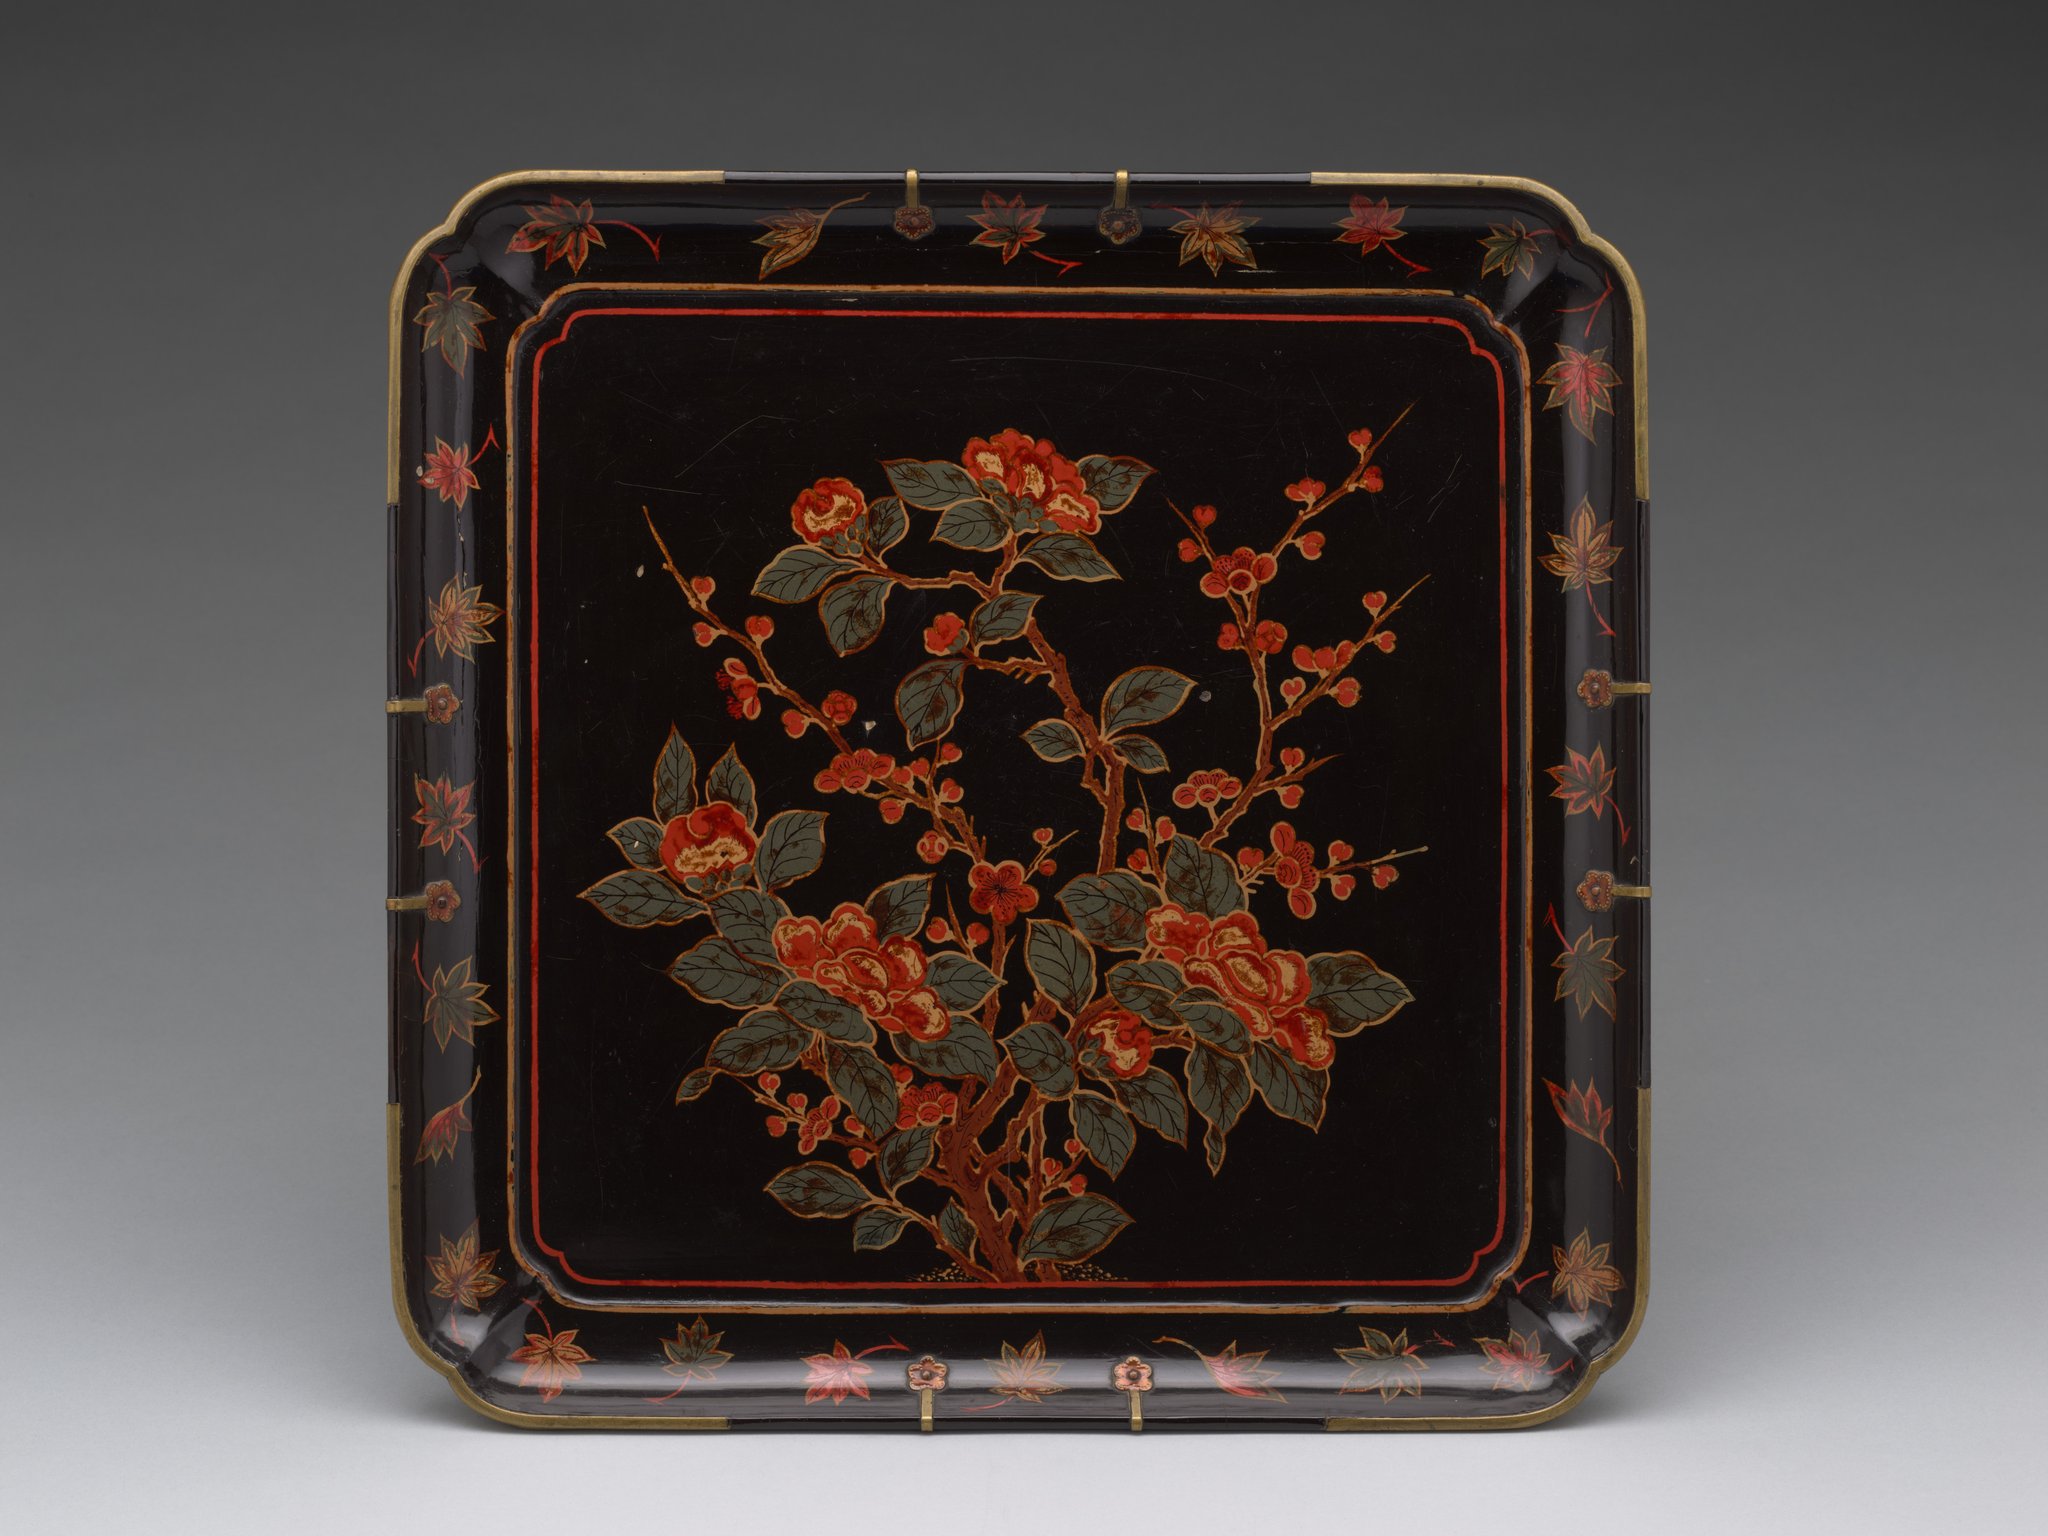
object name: tray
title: Square tray with floral decoration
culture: japanese or ryukyuan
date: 1701-1800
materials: brass, lacquer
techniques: painting, polychrome